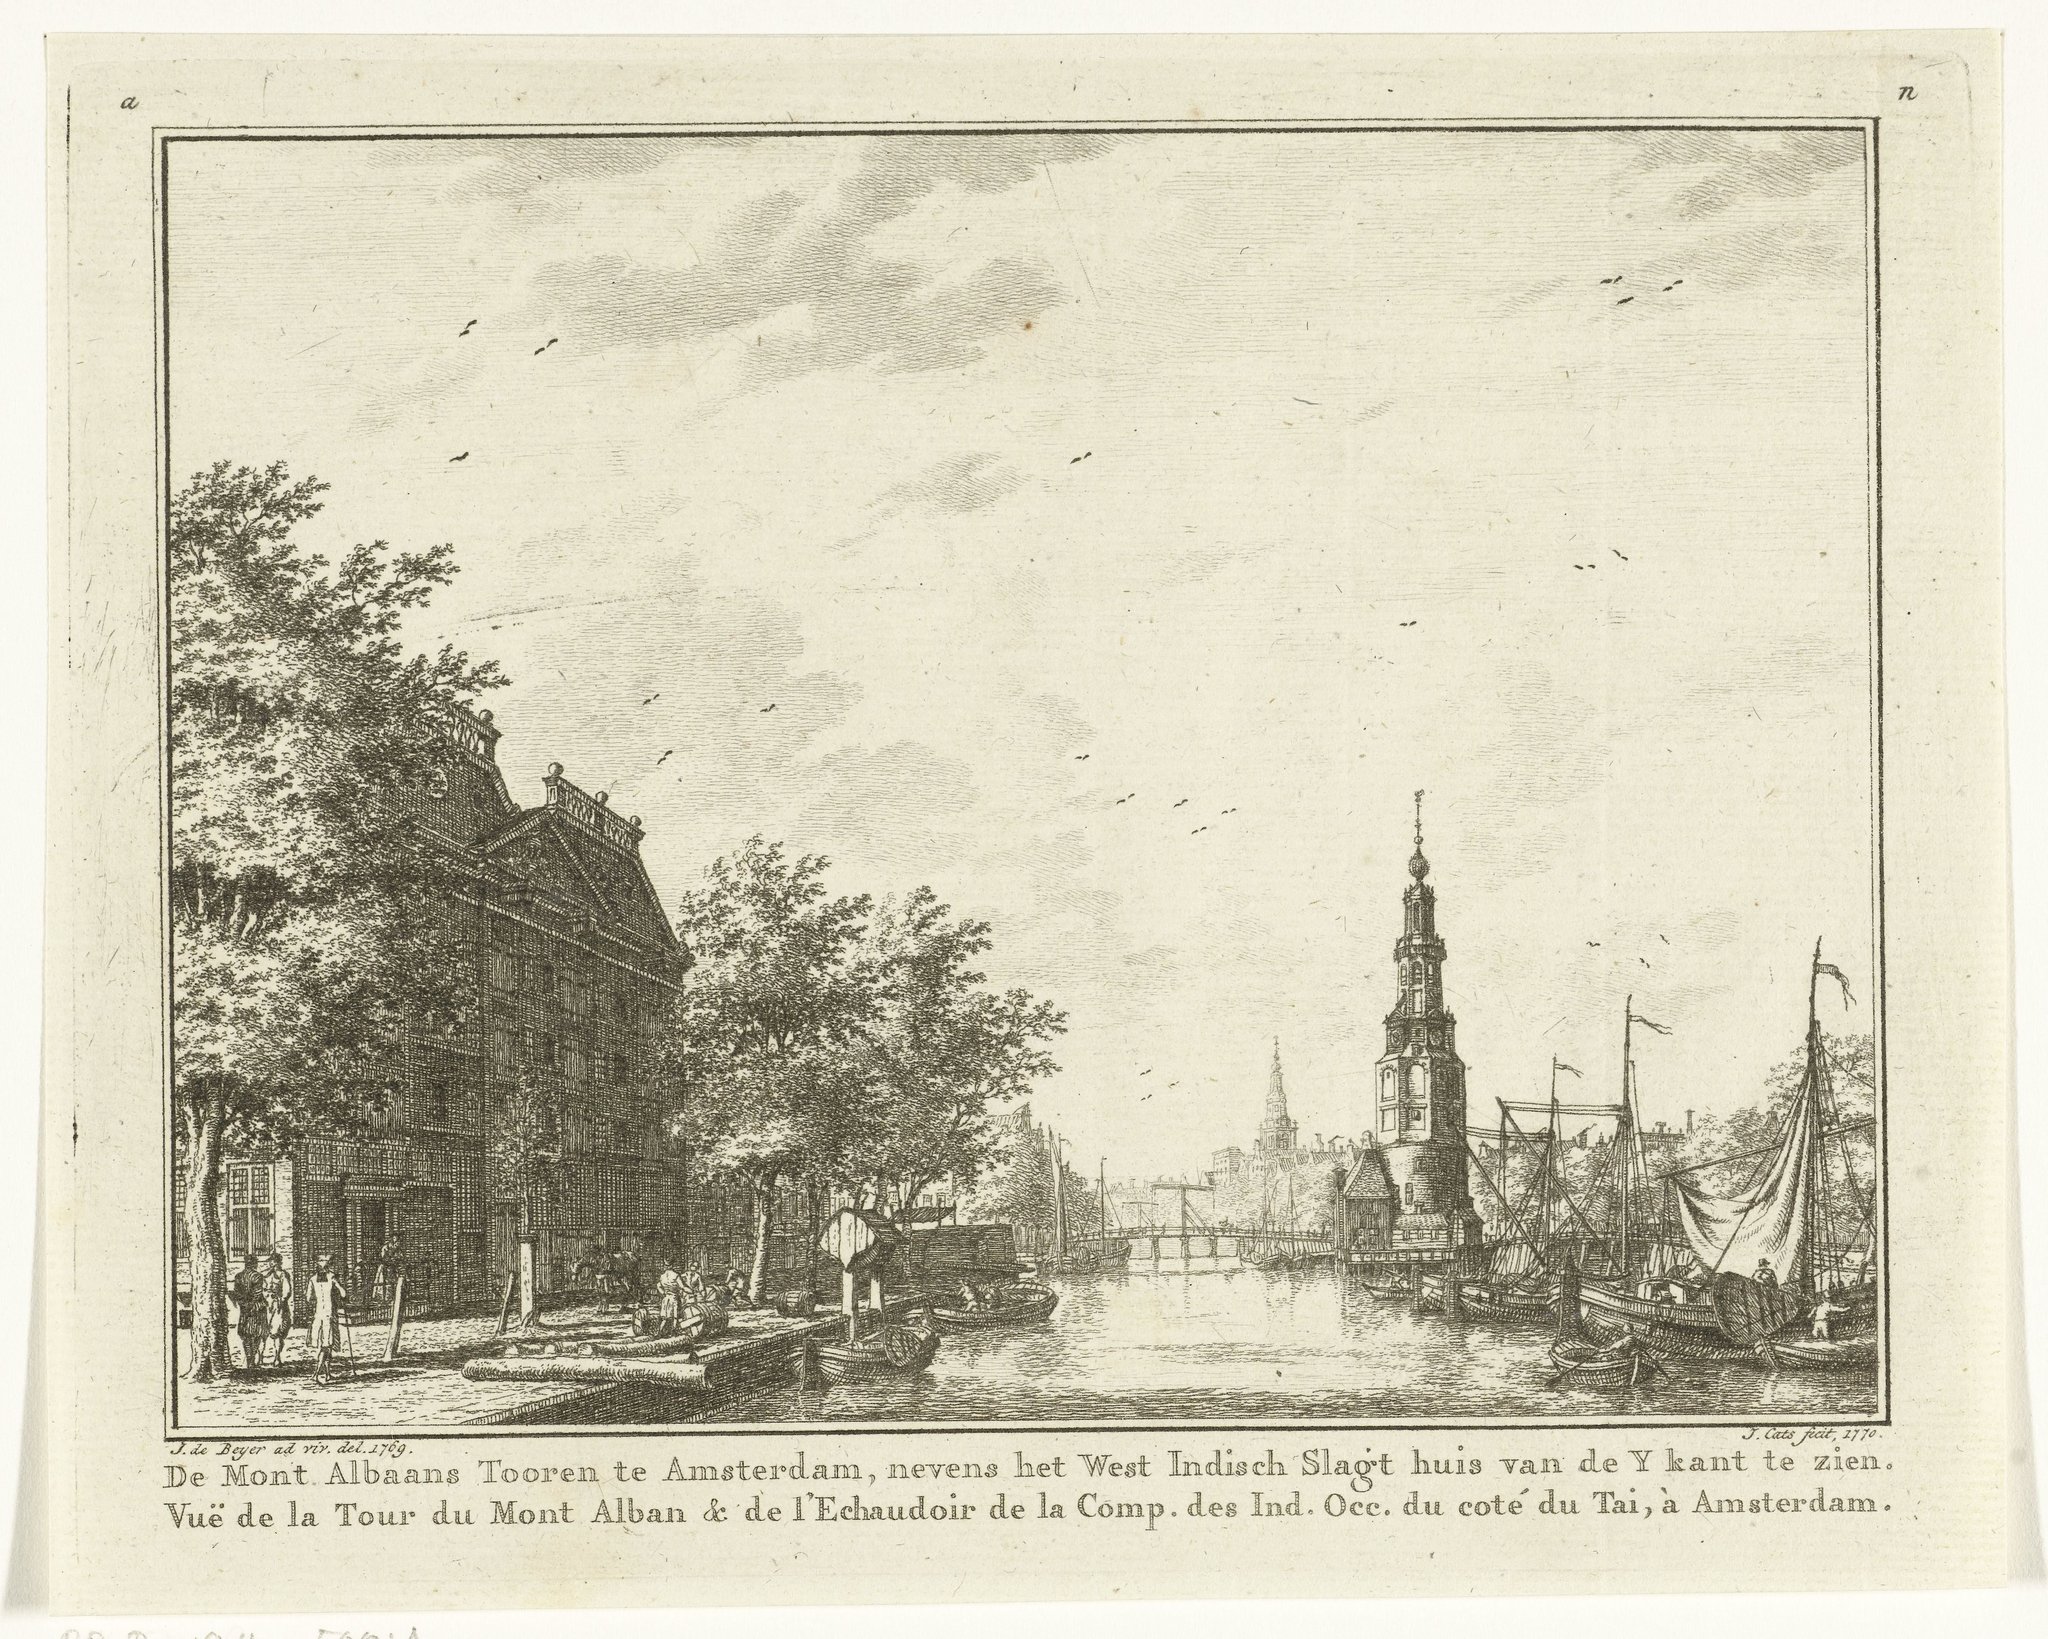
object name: print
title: Gezicht op de Montelbaanstoren in Amsterdam vanaf het IJ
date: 1770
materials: paper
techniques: etching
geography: amsterdam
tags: montelbaanstoren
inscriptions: date